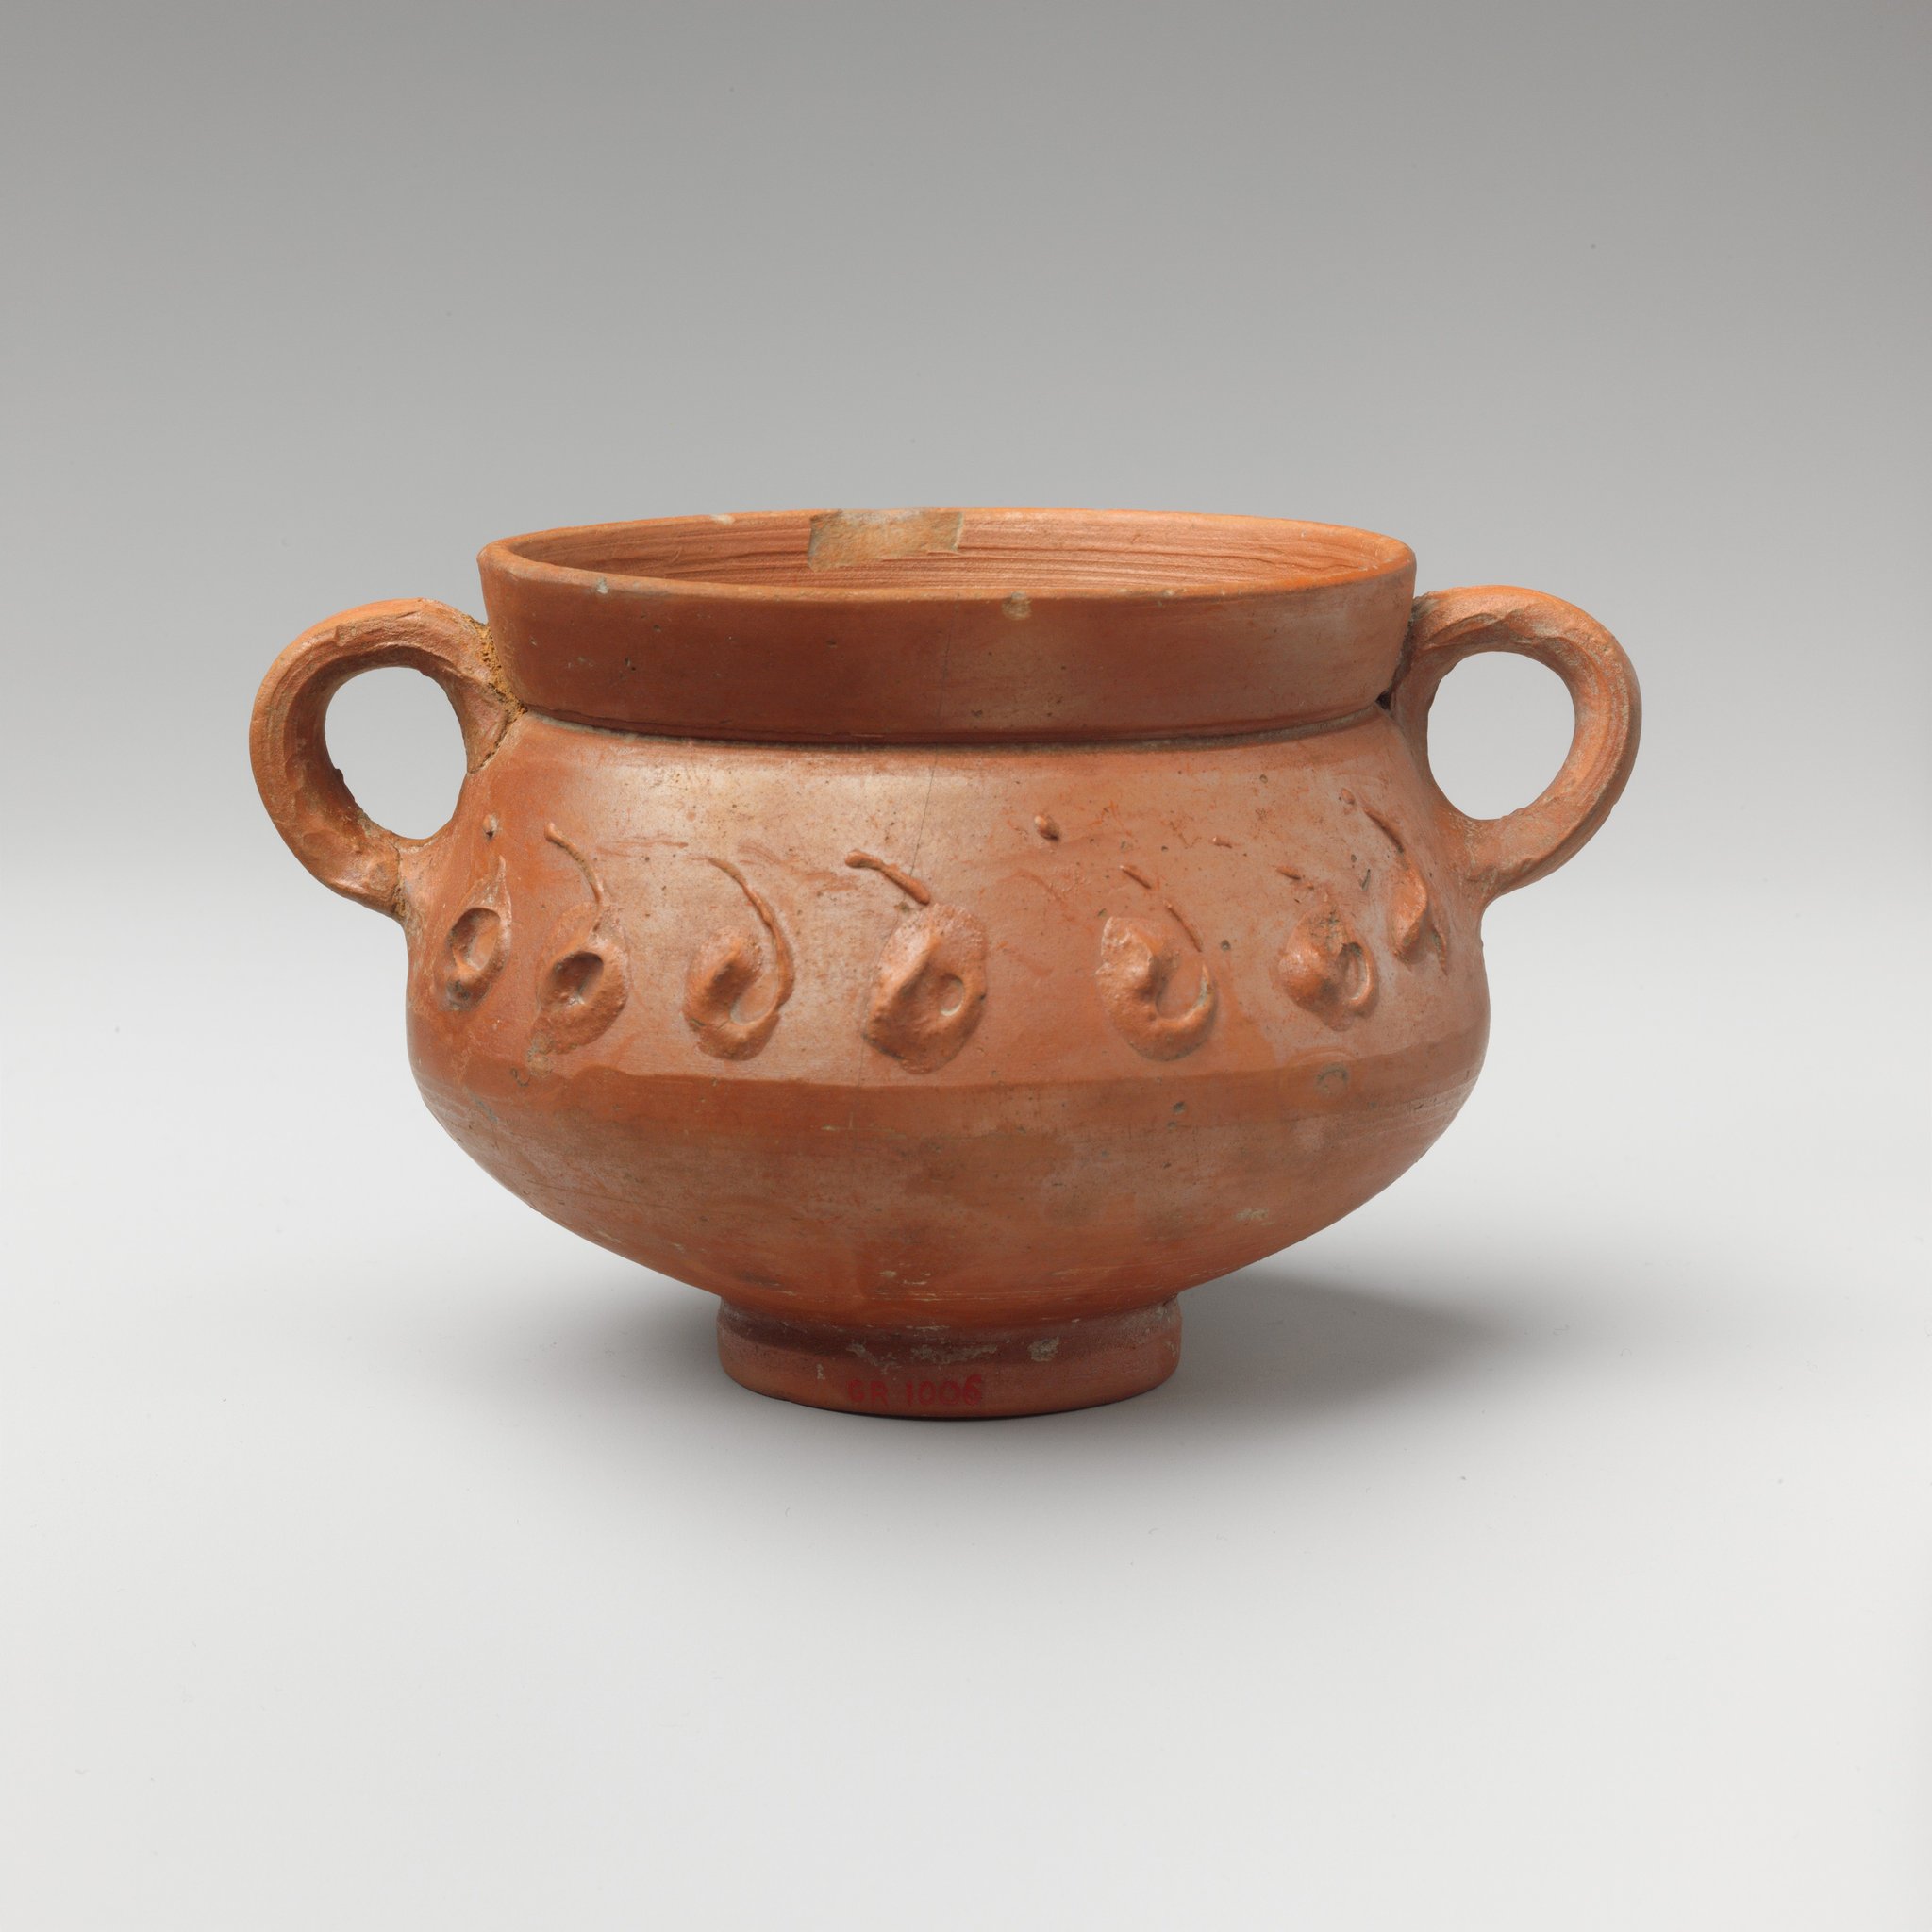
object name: cup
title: Terracotta cup with barbotine decoration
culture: roman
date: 34-66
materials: terracotta